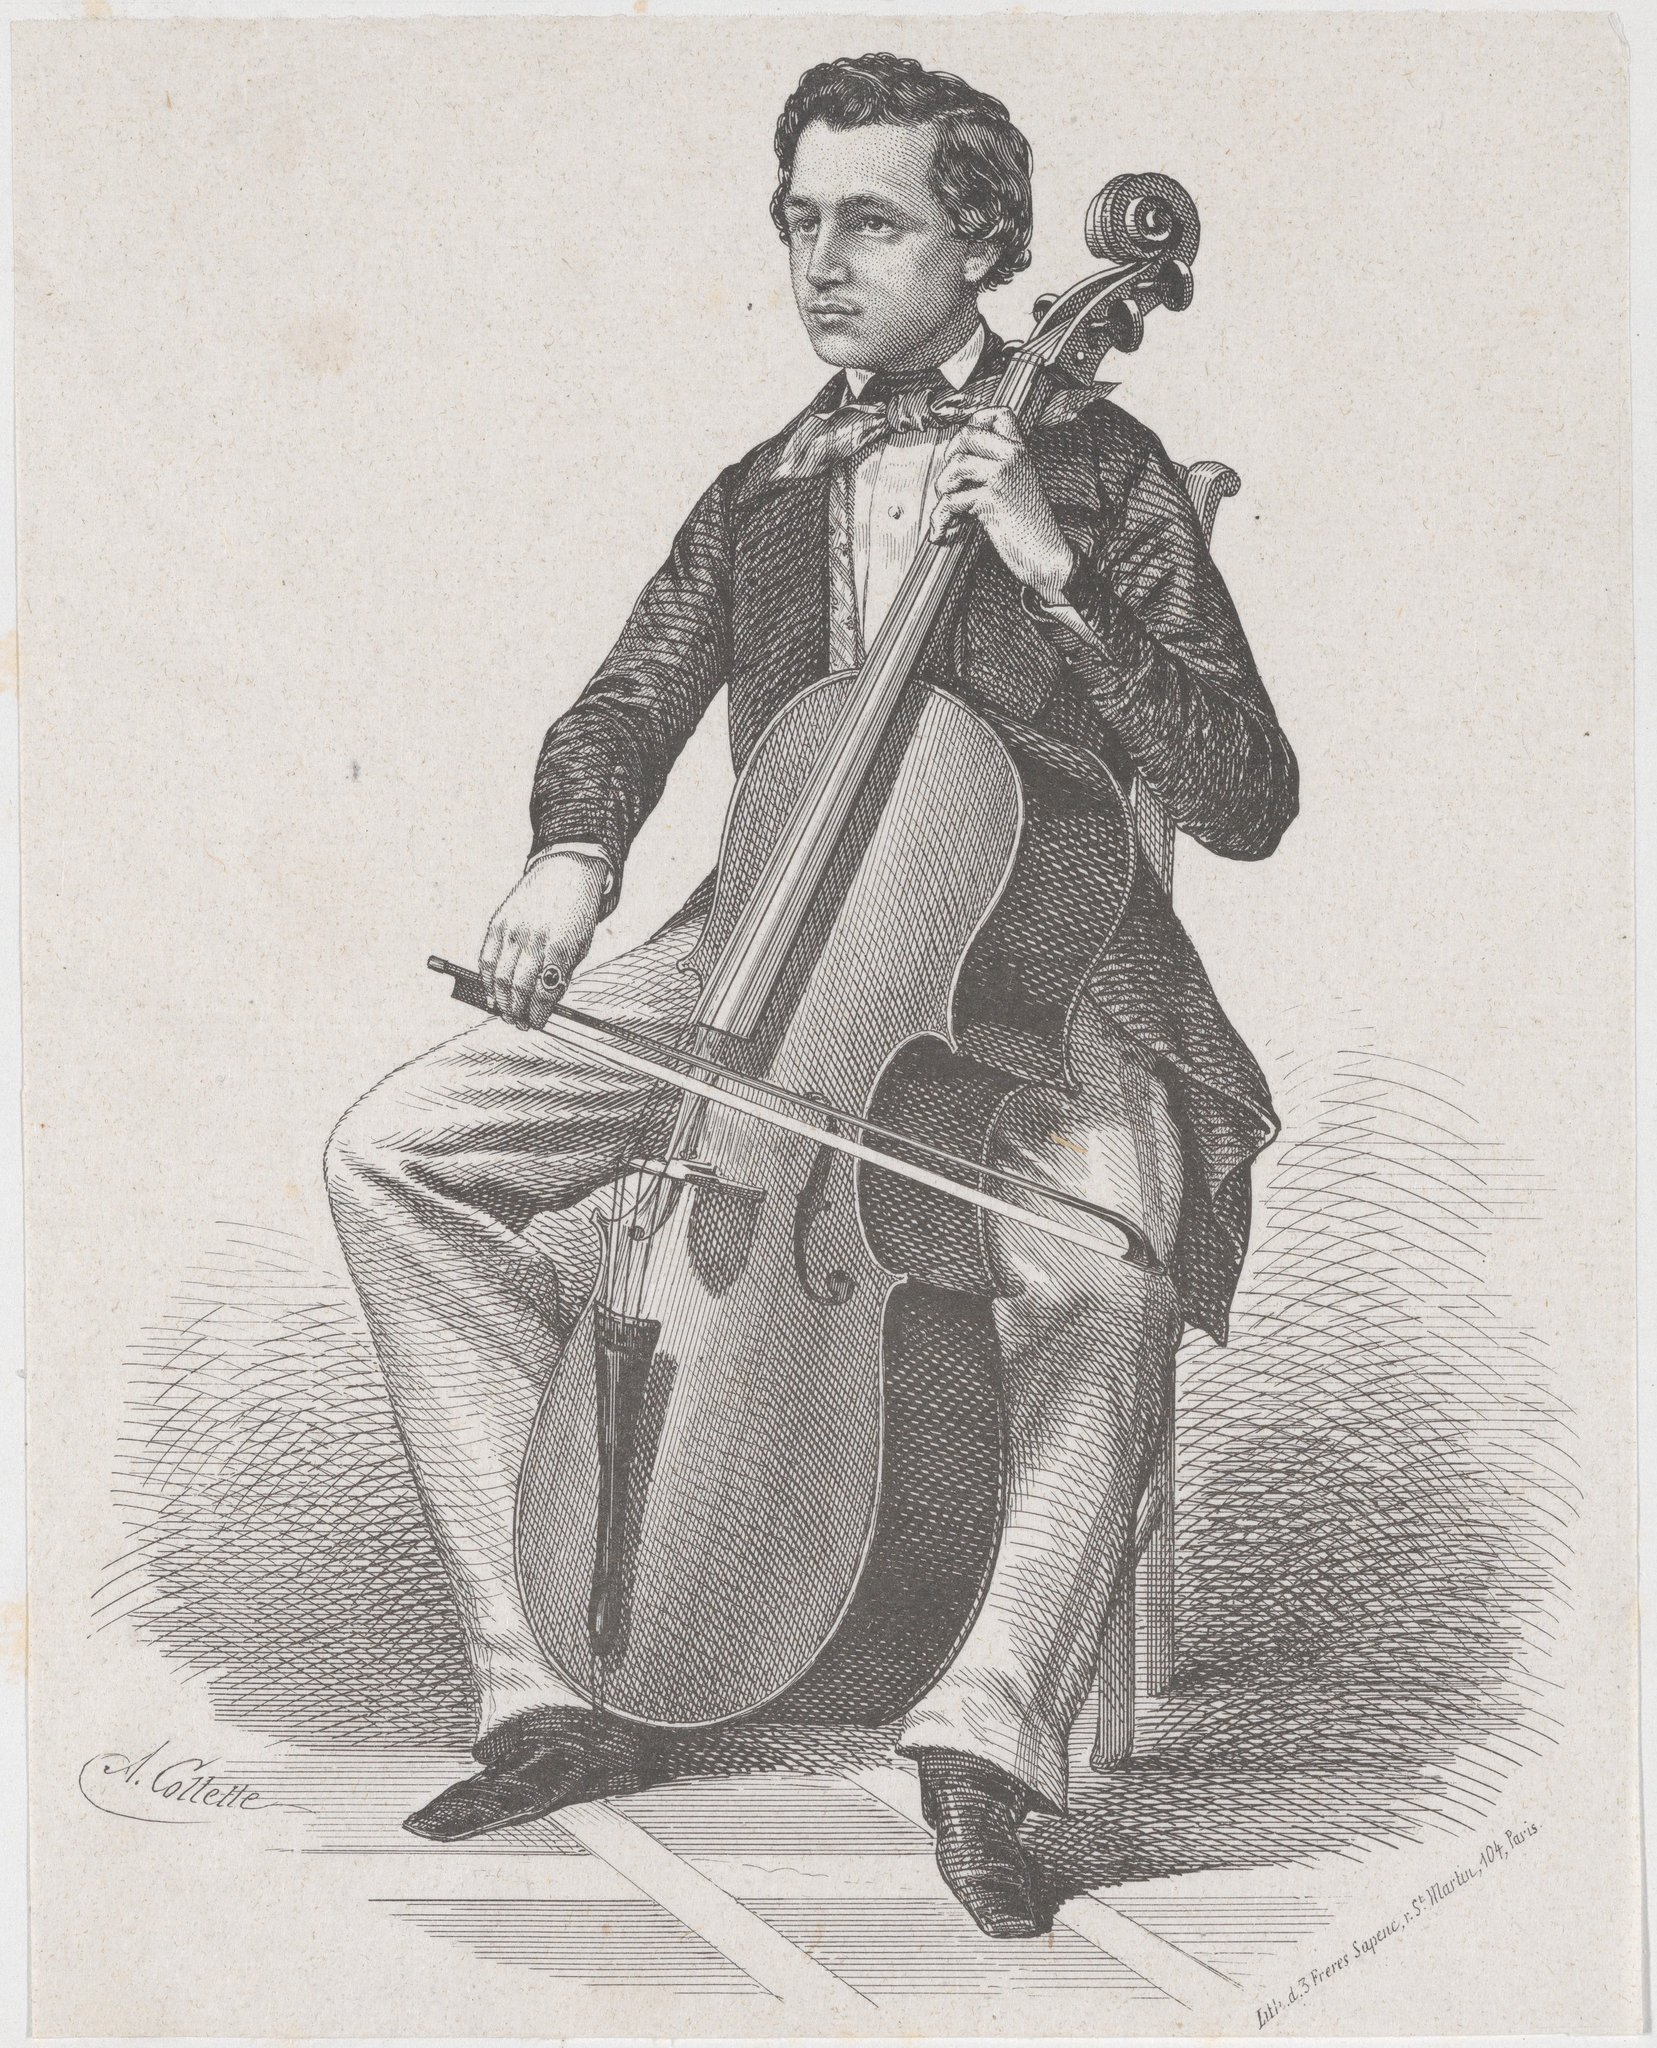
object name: lithographic plate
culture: french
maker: alexandre désiré collette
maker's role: print maker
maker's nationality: french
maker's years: 1814-1876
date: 1850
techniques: lithograph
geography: france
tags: musical instruments,men,musicians